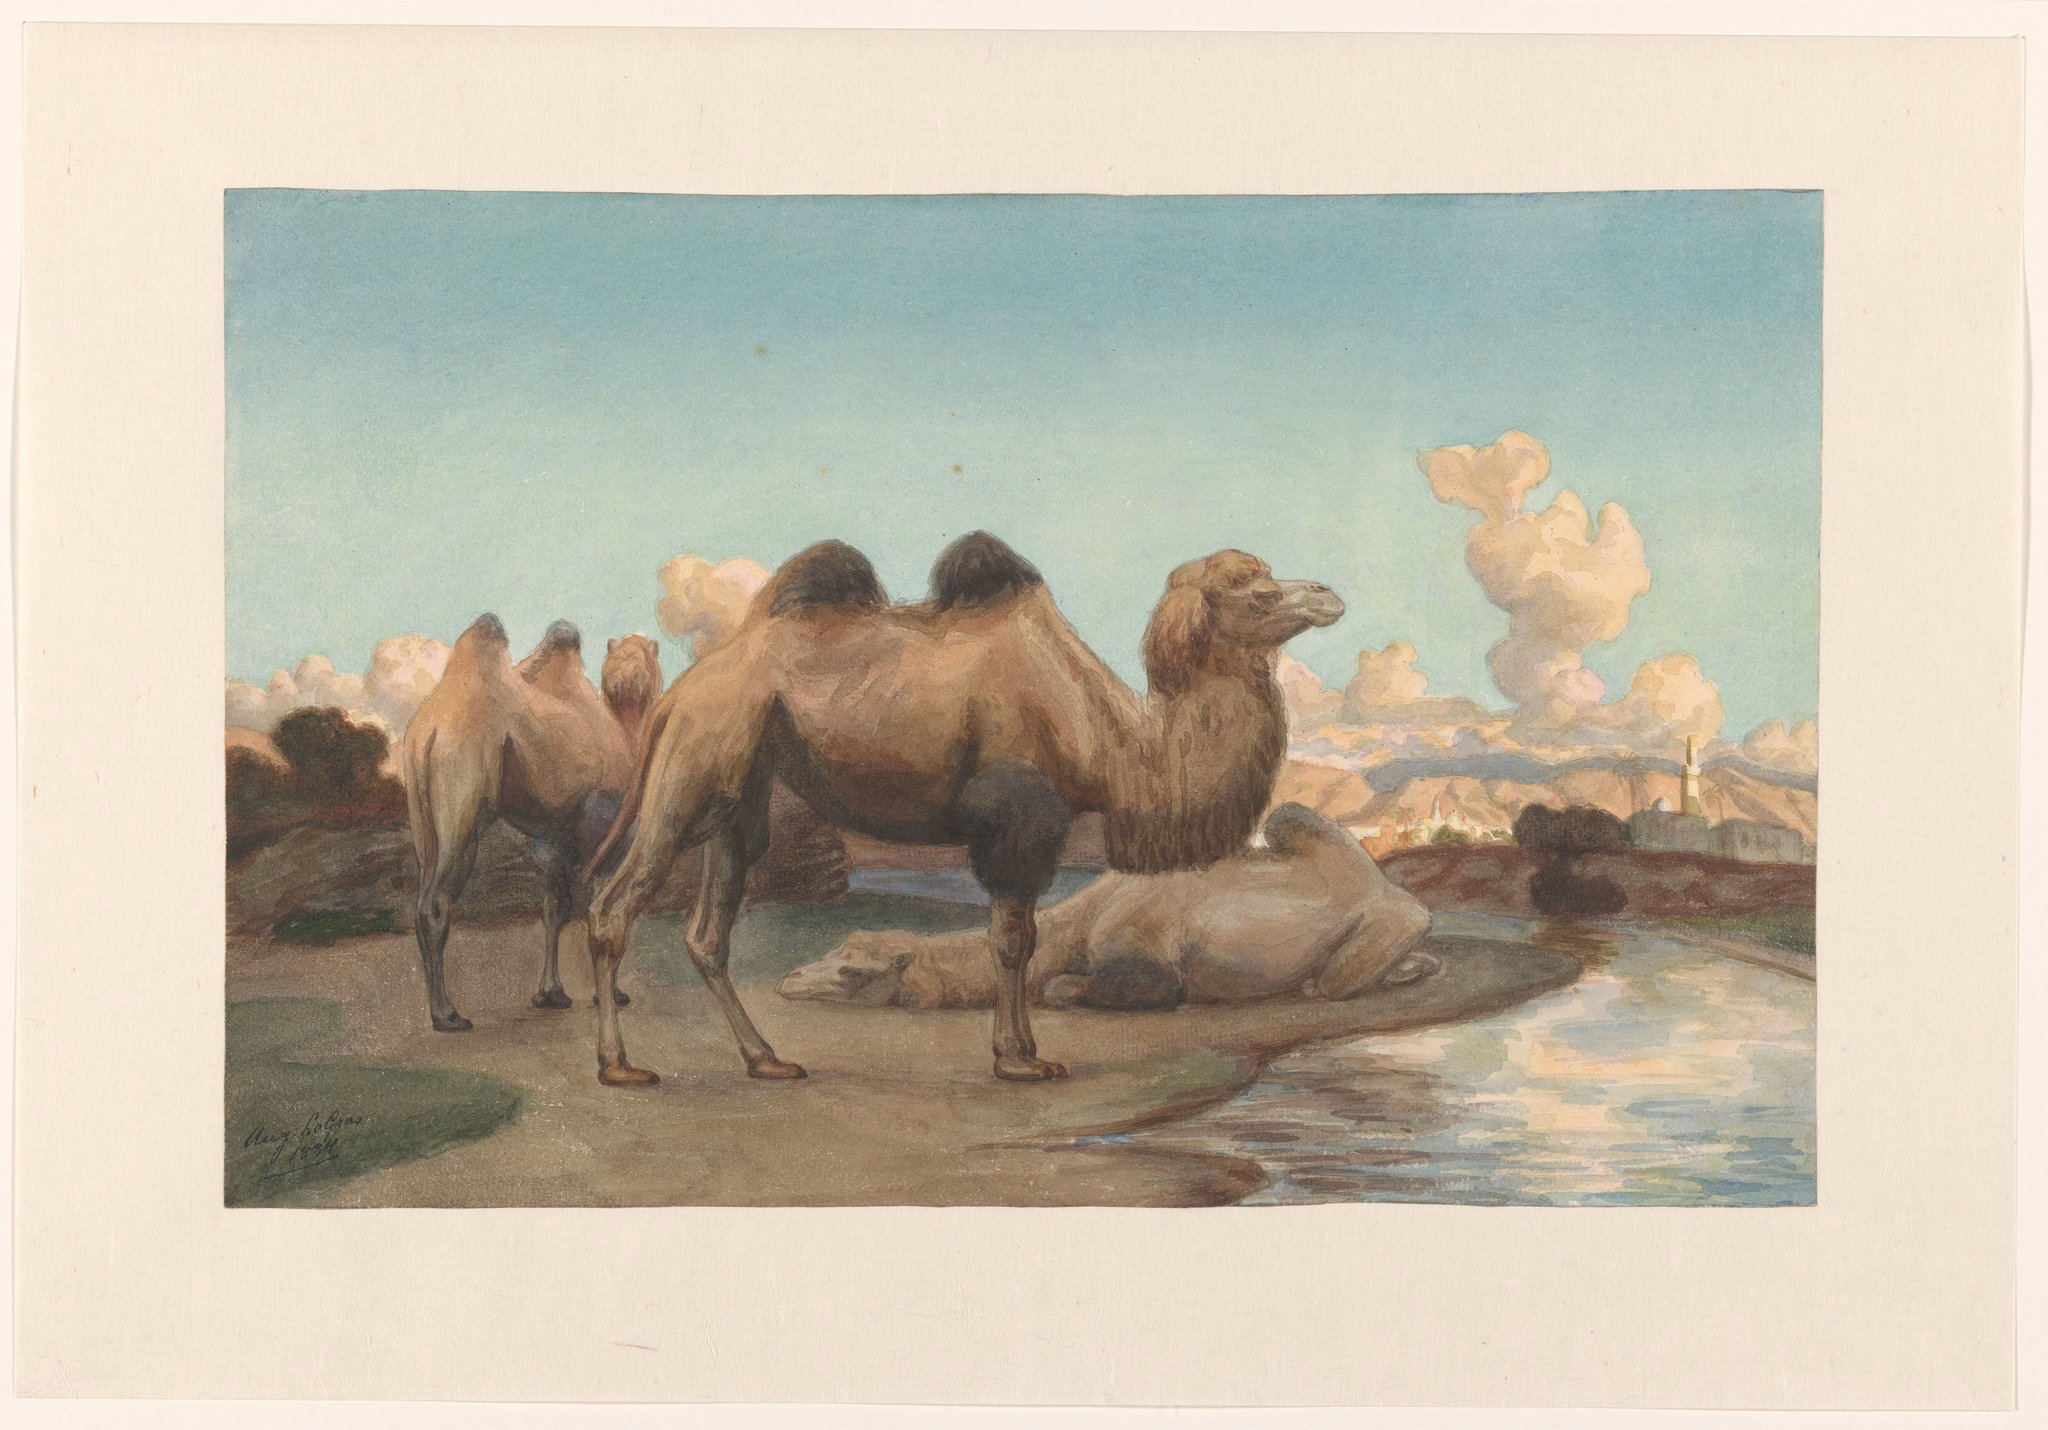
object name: drawing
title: Kamelen in een landschap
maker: august le gras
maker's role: draughtsman, print maker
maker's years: 1864-1915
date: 1884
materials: paper, watercolor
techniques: brush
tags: hoofed animals: camel